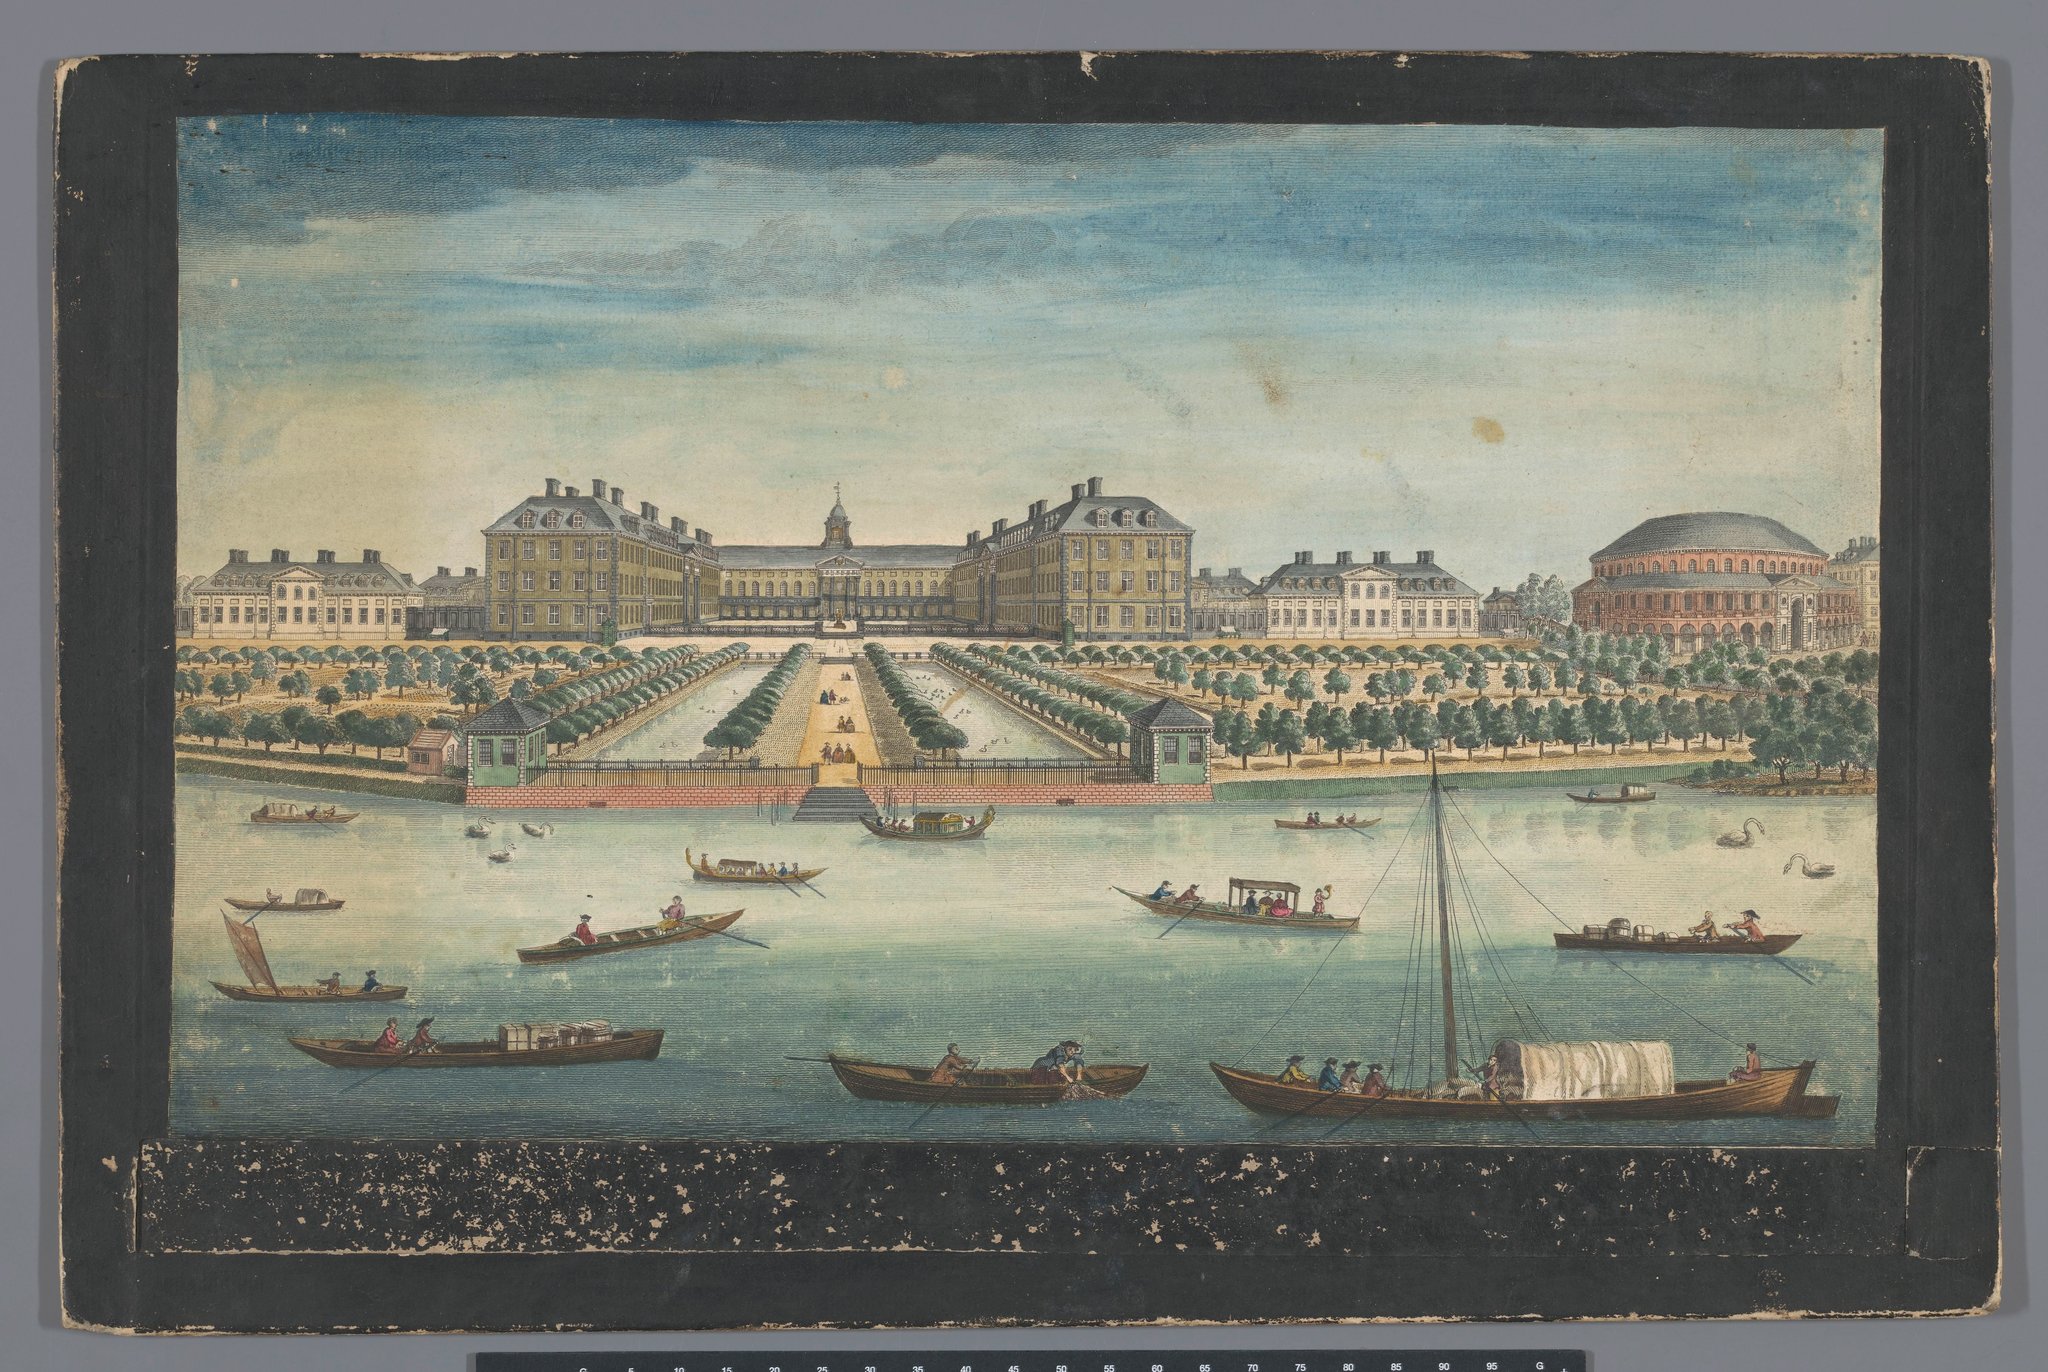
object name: print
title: A view of the Royal Hospital at Chelsea & the Rotunda in Ranelaigh Gardens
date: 1751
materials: cardboard, paper, watercolor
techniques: brush, etching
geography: london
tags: garden, hospital, civic architecture; edifices; dwellings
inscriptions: collector's mark: Lugt 2233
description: De serie “Londen” bevat 52 prenten met de nummers 1-52, waarvan dit nummer 37 is.